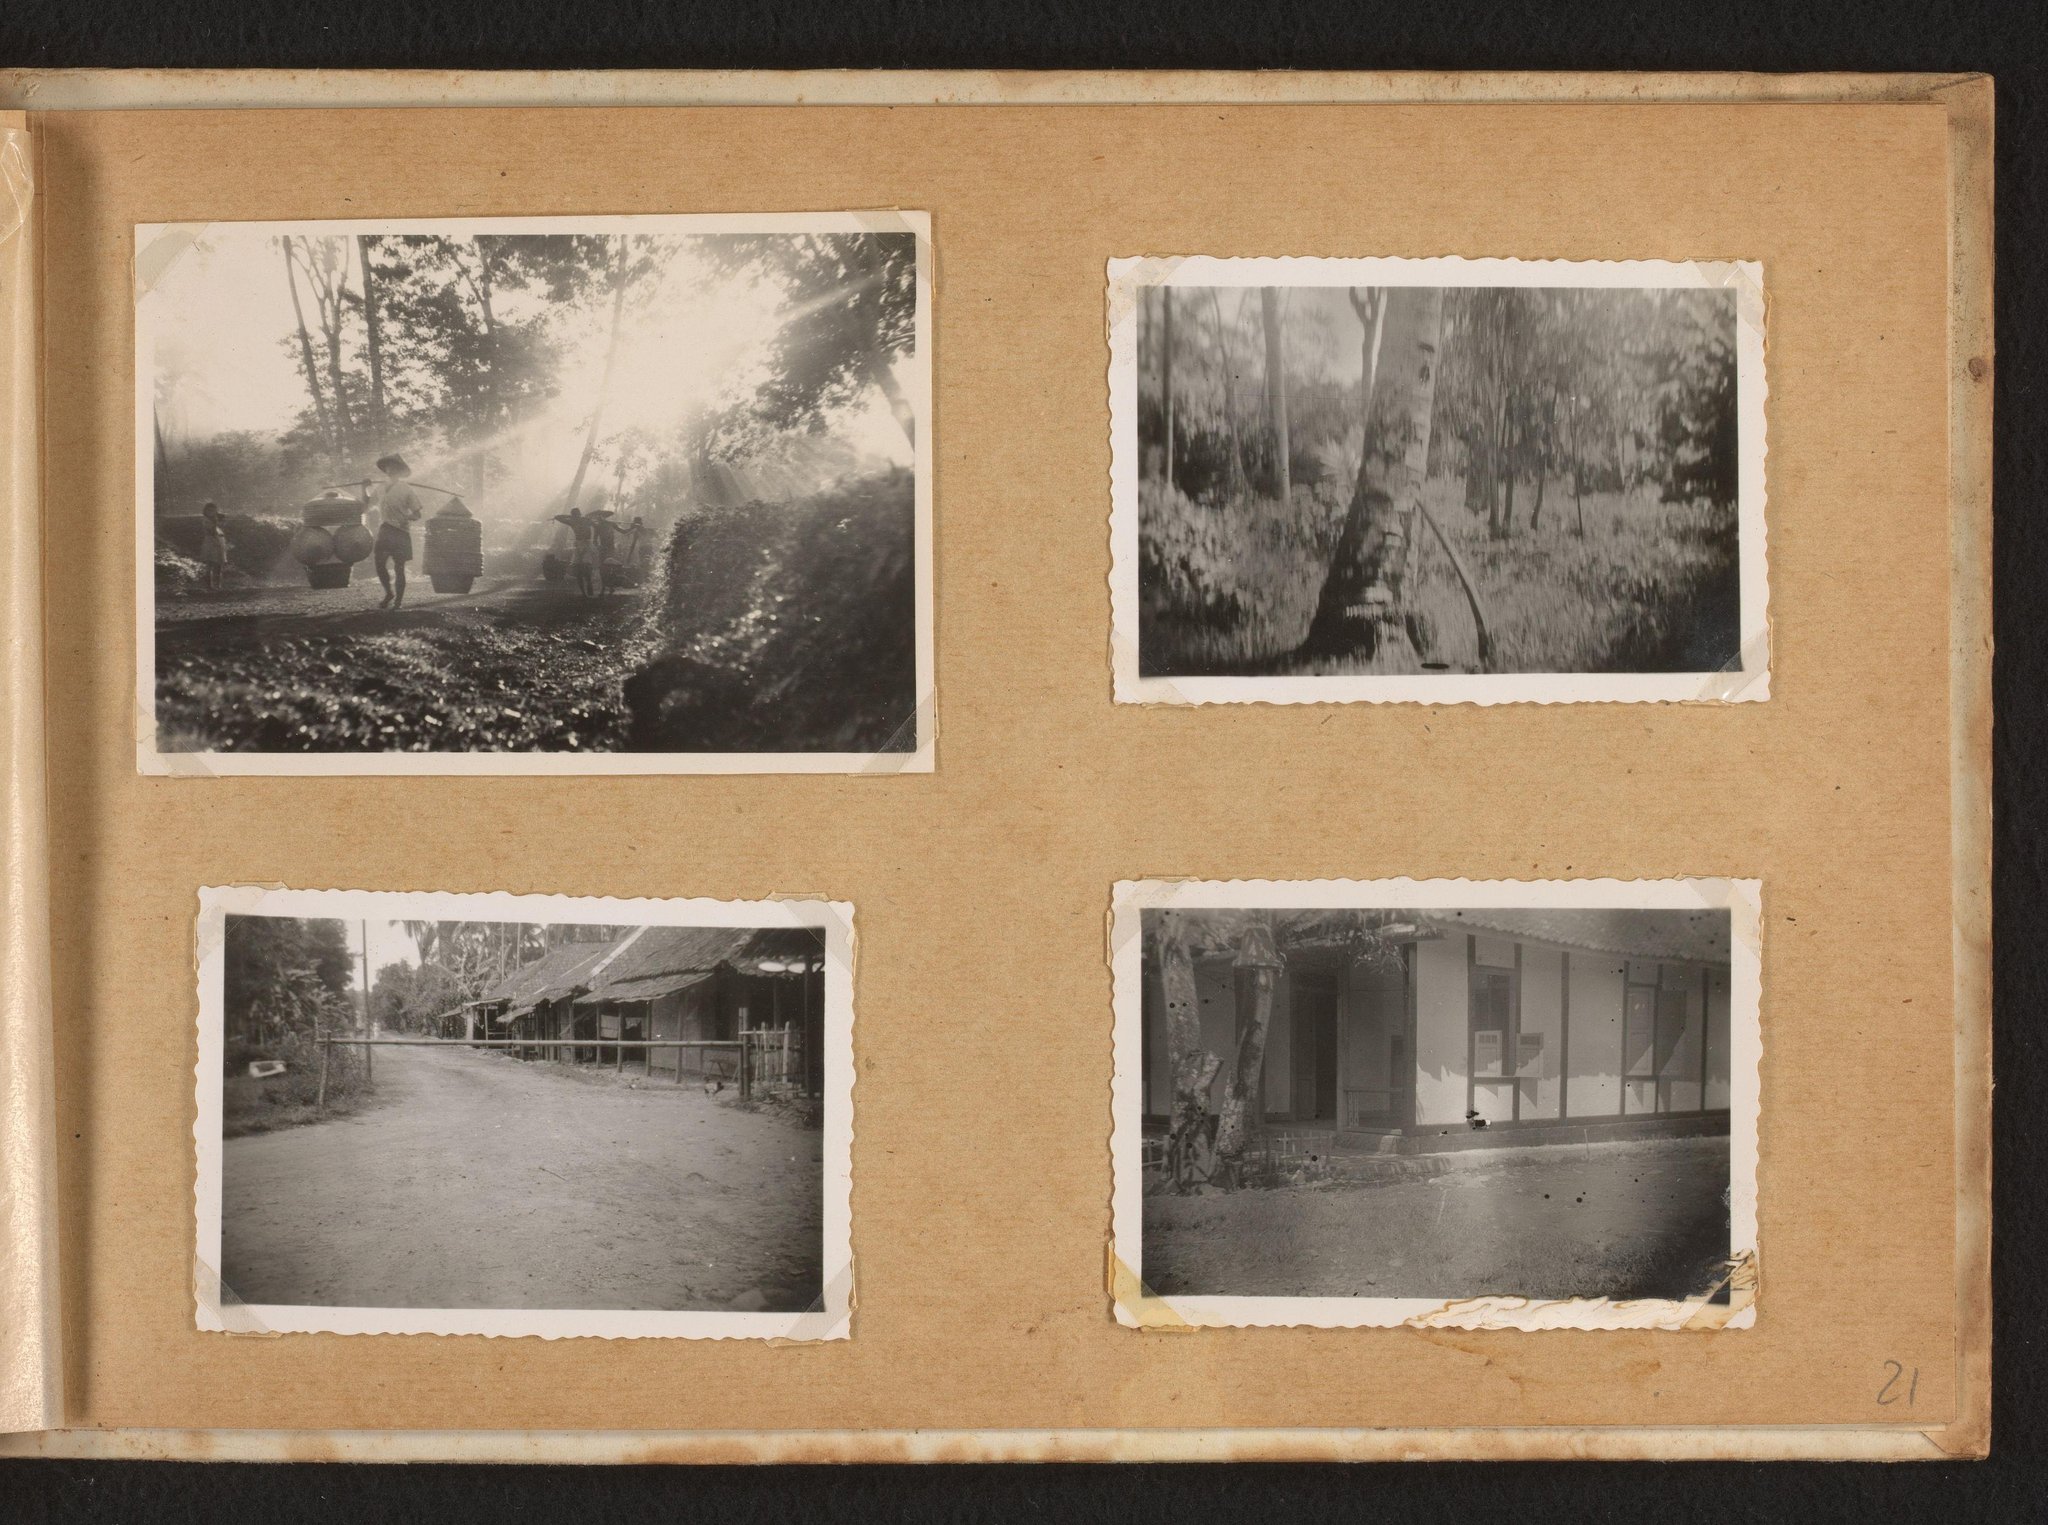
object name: photograph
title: Dorp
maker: Anonymous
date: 1948-1949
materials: cardboard, photographic support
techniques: gelatin silver print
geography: dutch east indies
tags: village, dutch east indies, the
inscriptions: inscription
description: Albumblad met vier foto's van een dorp en de lokale bevolking. Onderdeel van het fotoalbum 'Ter herinnering aan mijn diensttijd overzee' 1948-1949.